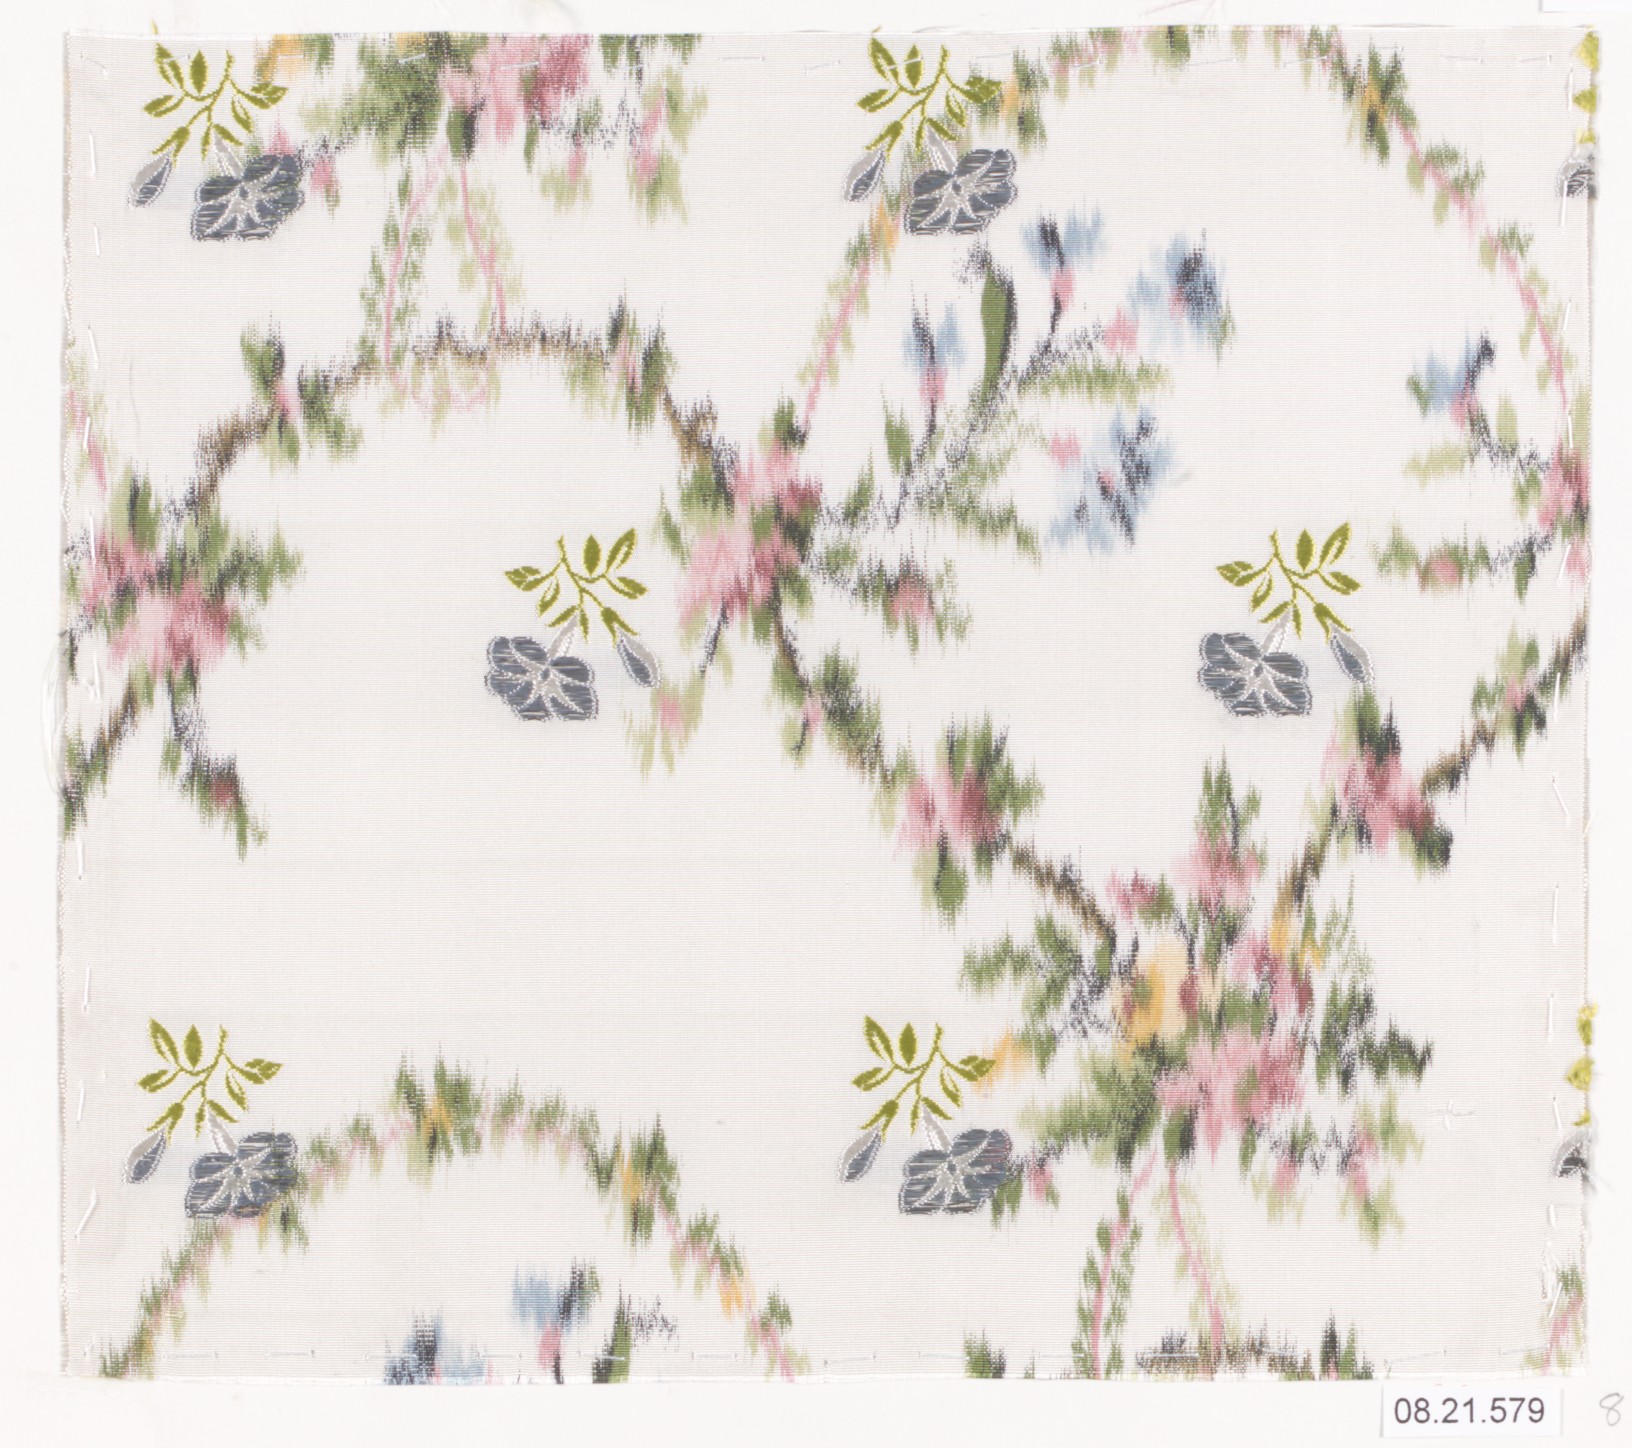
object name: textile sample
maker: Anonymous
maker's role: designer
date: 1900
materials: silk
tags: flowers